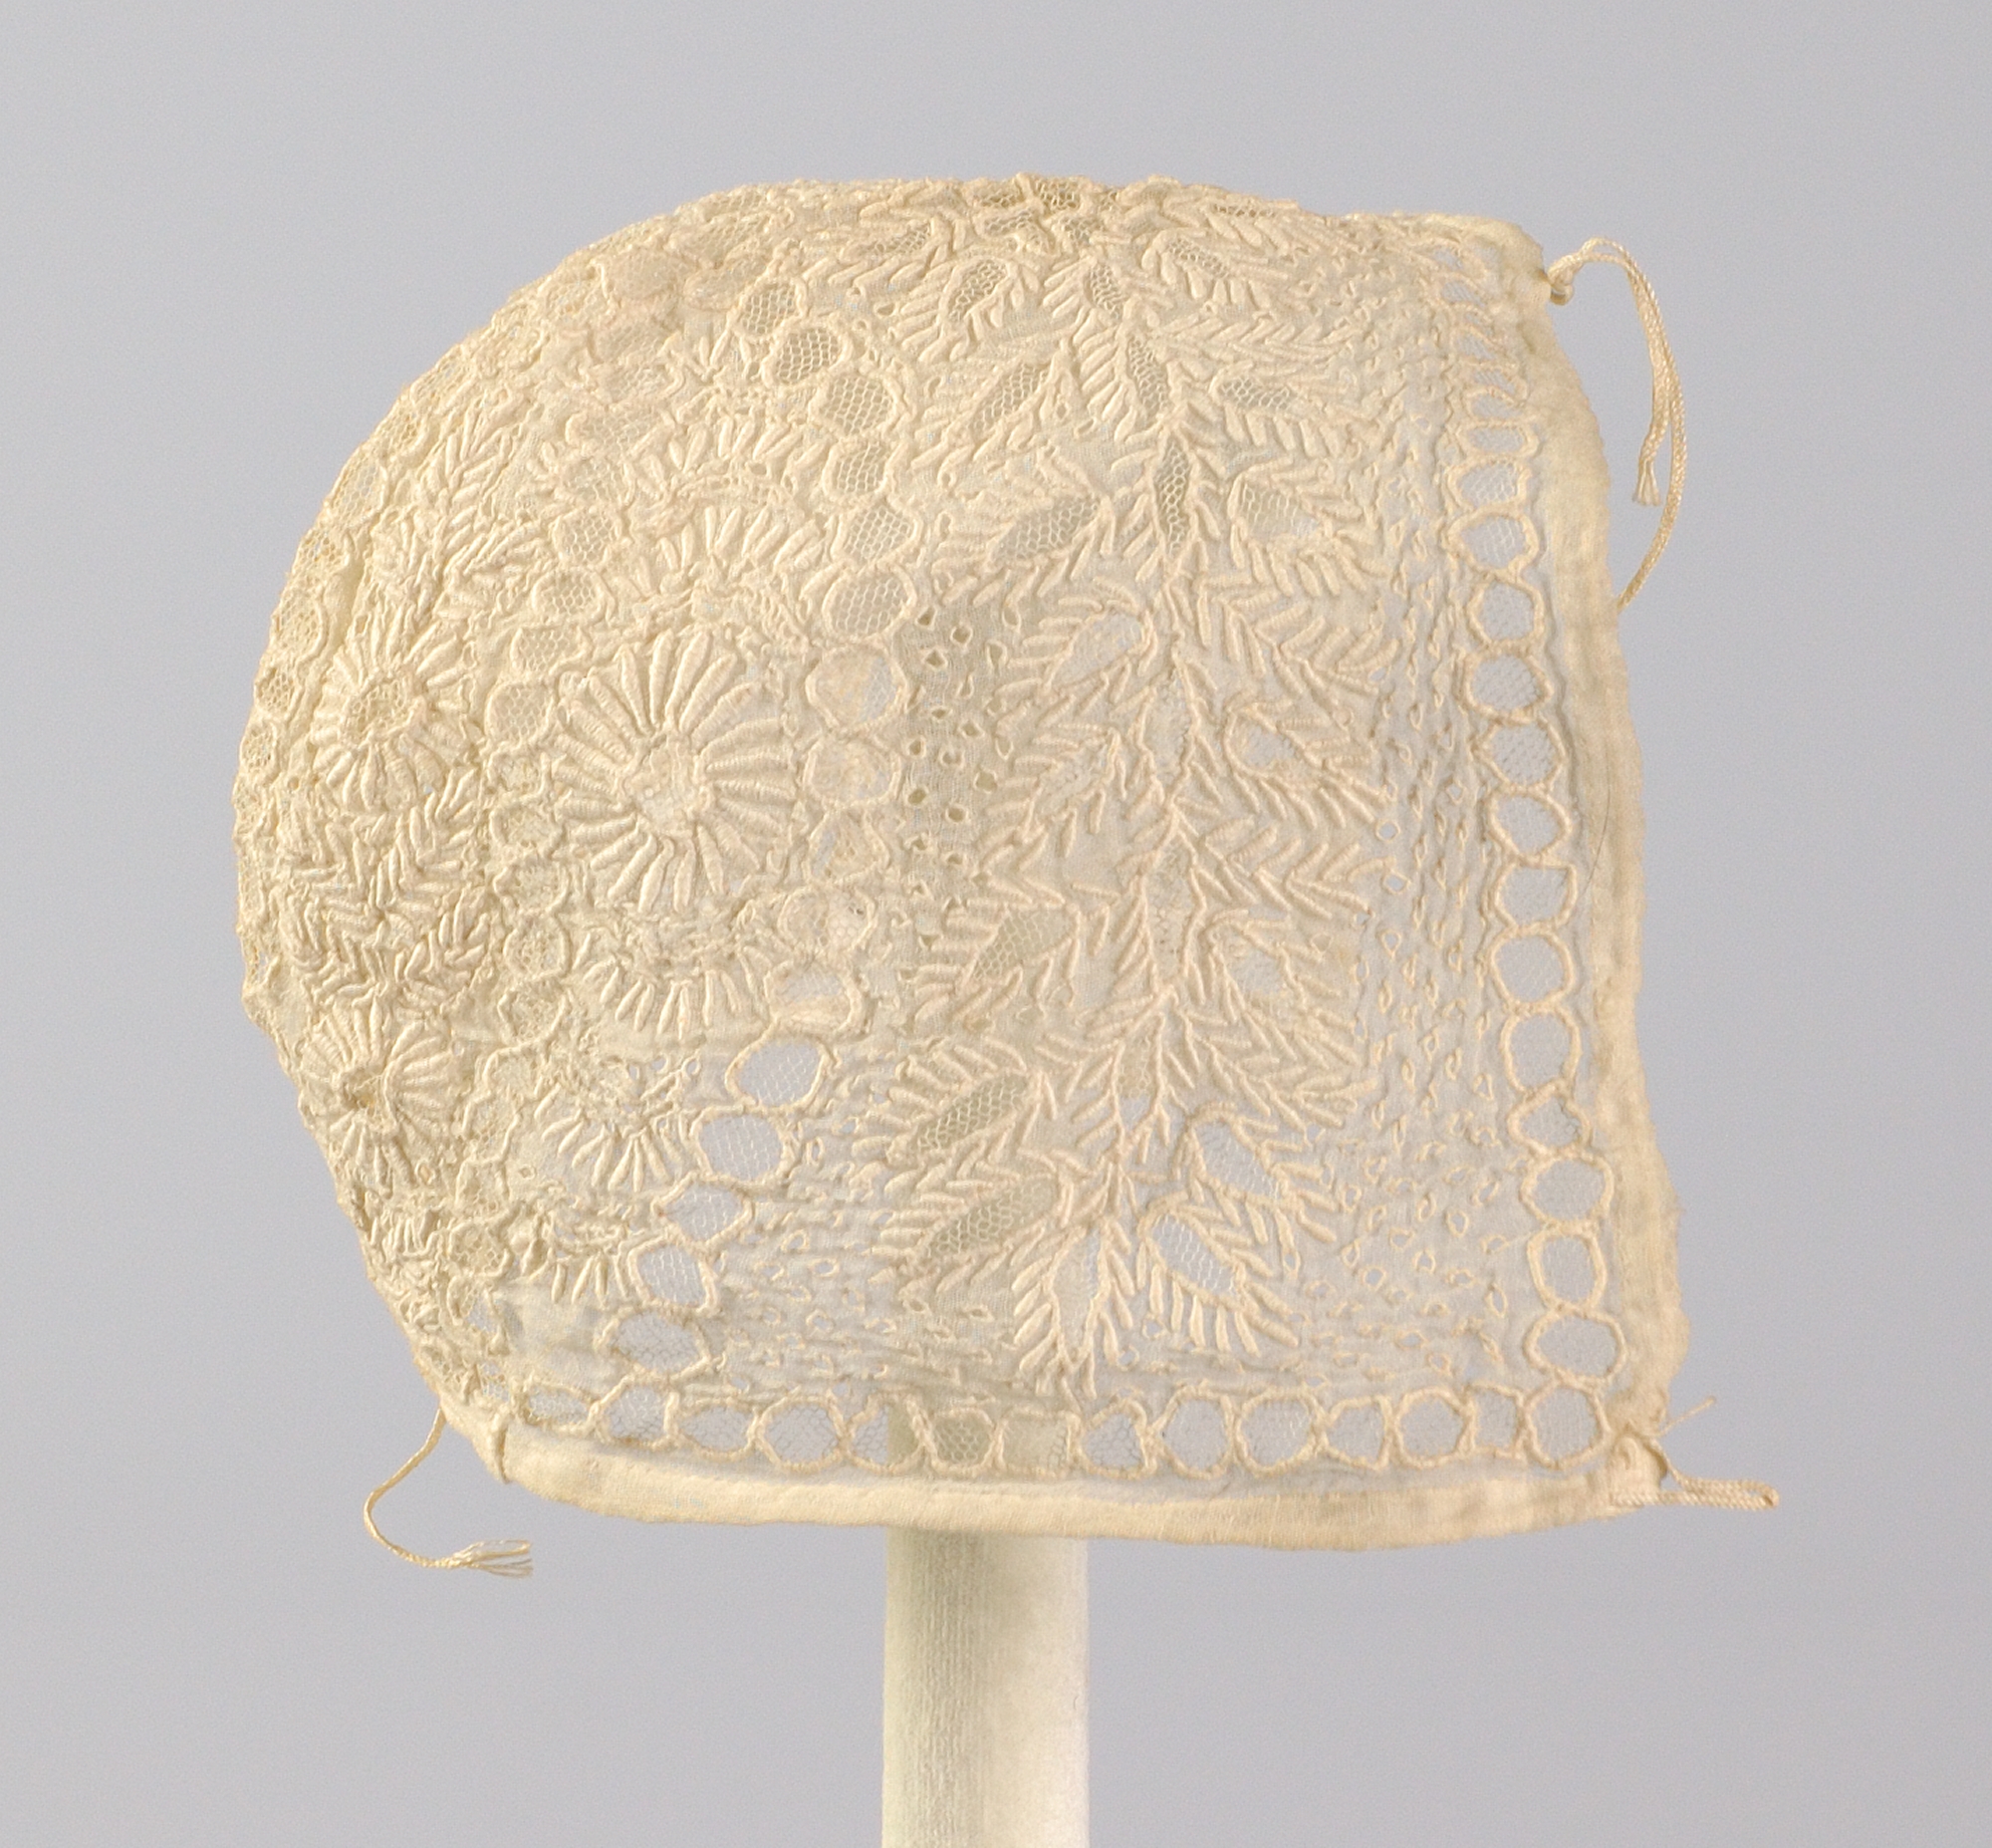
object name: cap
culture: american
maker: abigail lloyd lott zabriskie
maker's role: maker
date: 1831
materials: cotton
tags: flowers